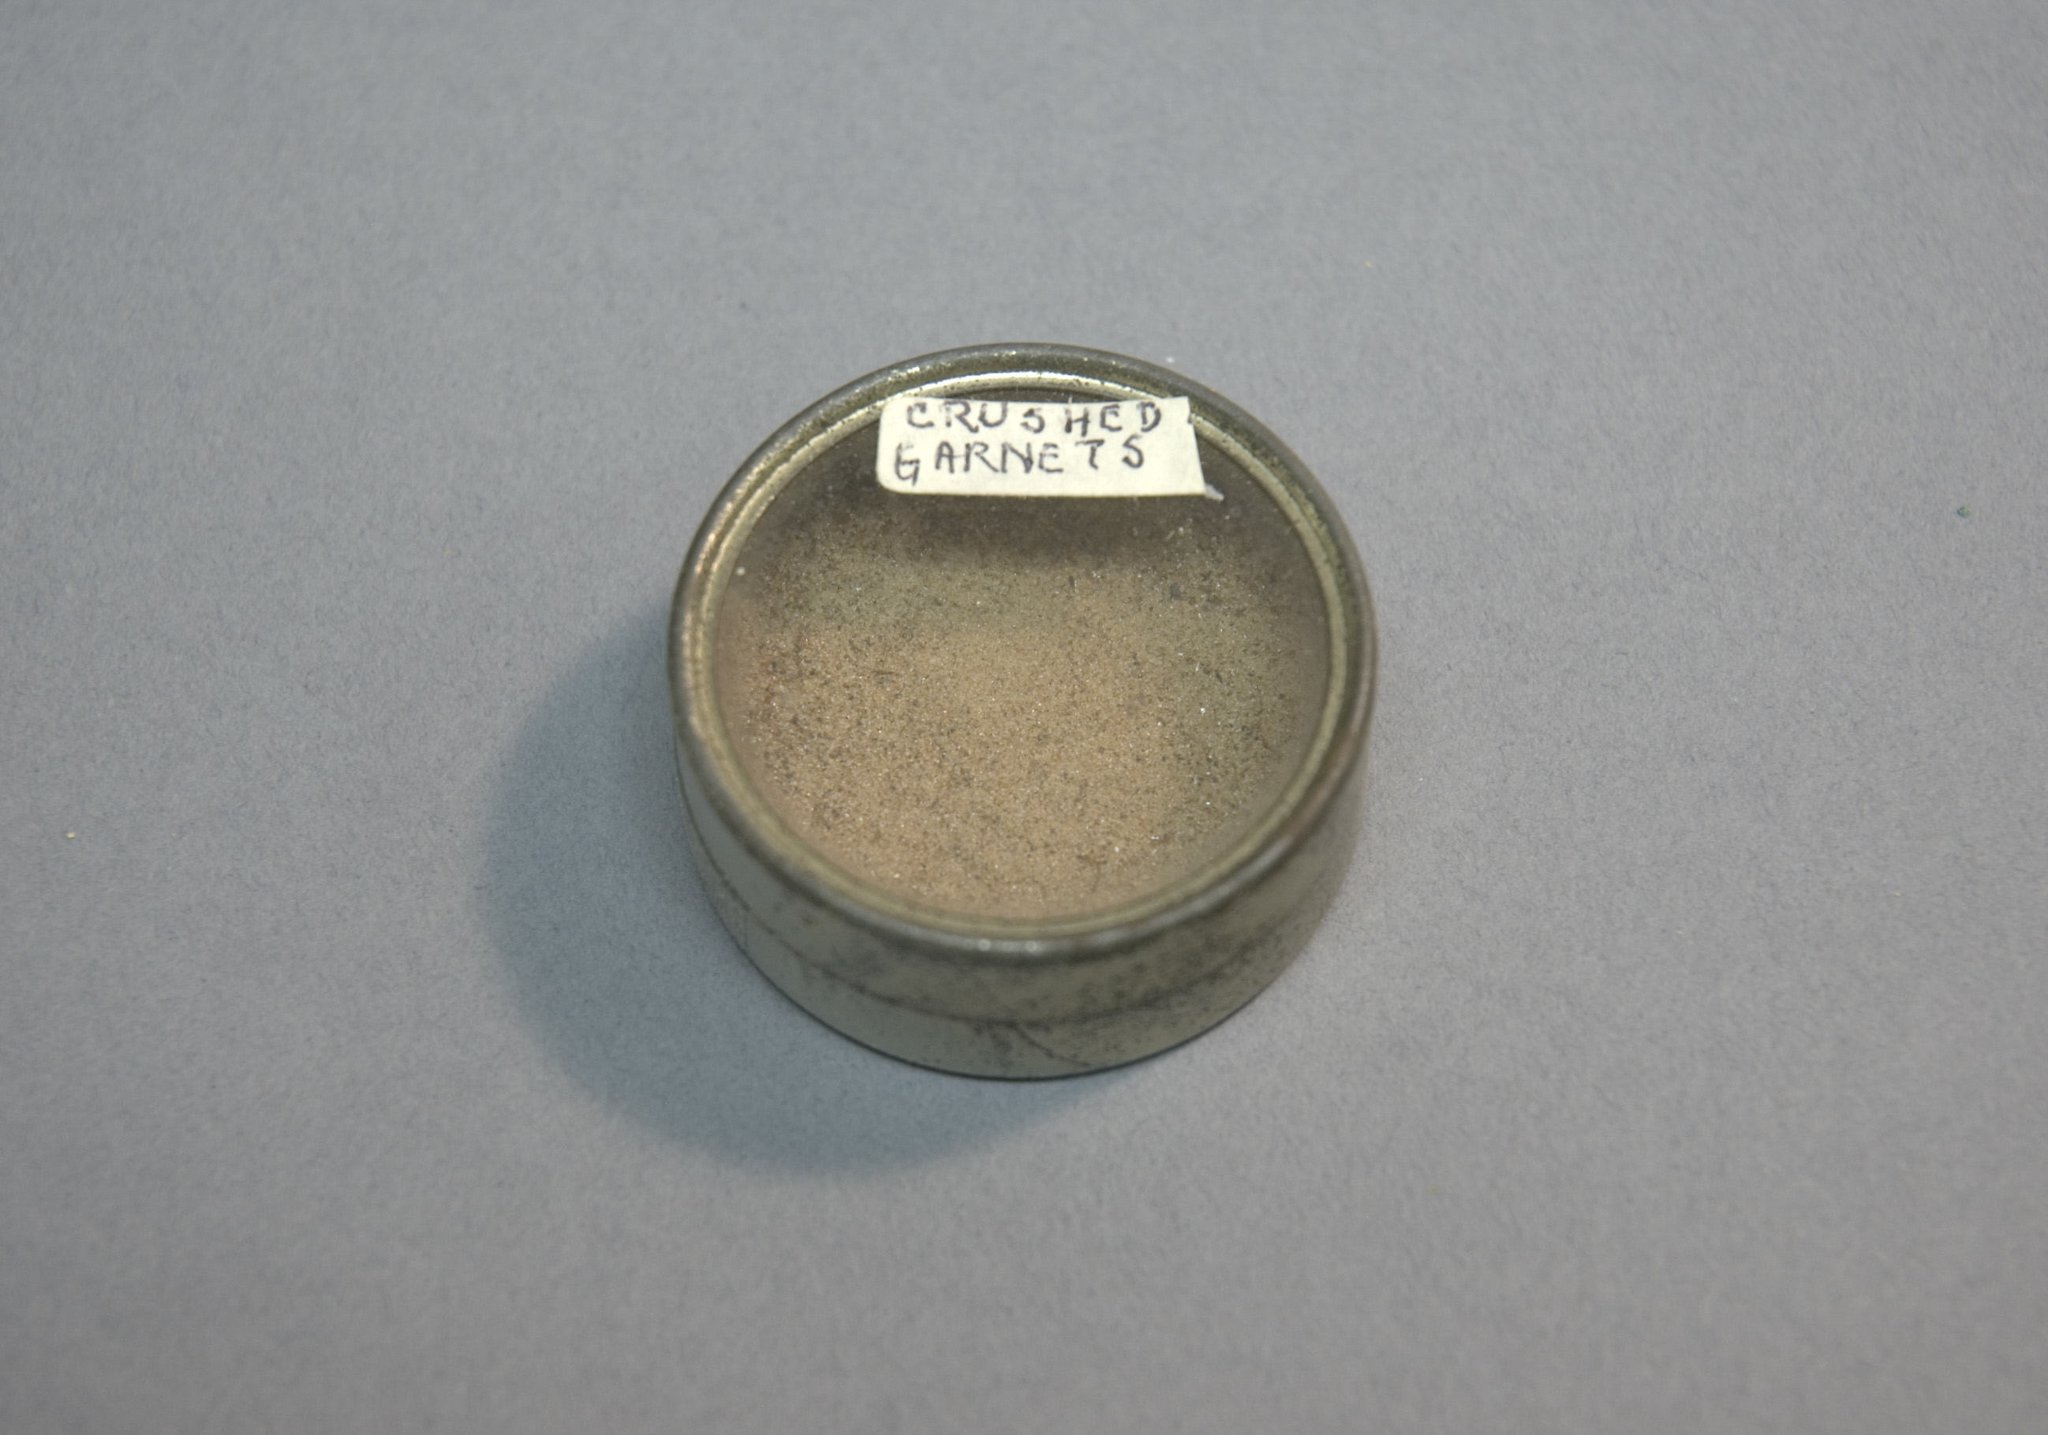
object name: jade carving material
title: Container of Crushed Garnets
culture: chinese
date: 1901-2000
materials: gemstone